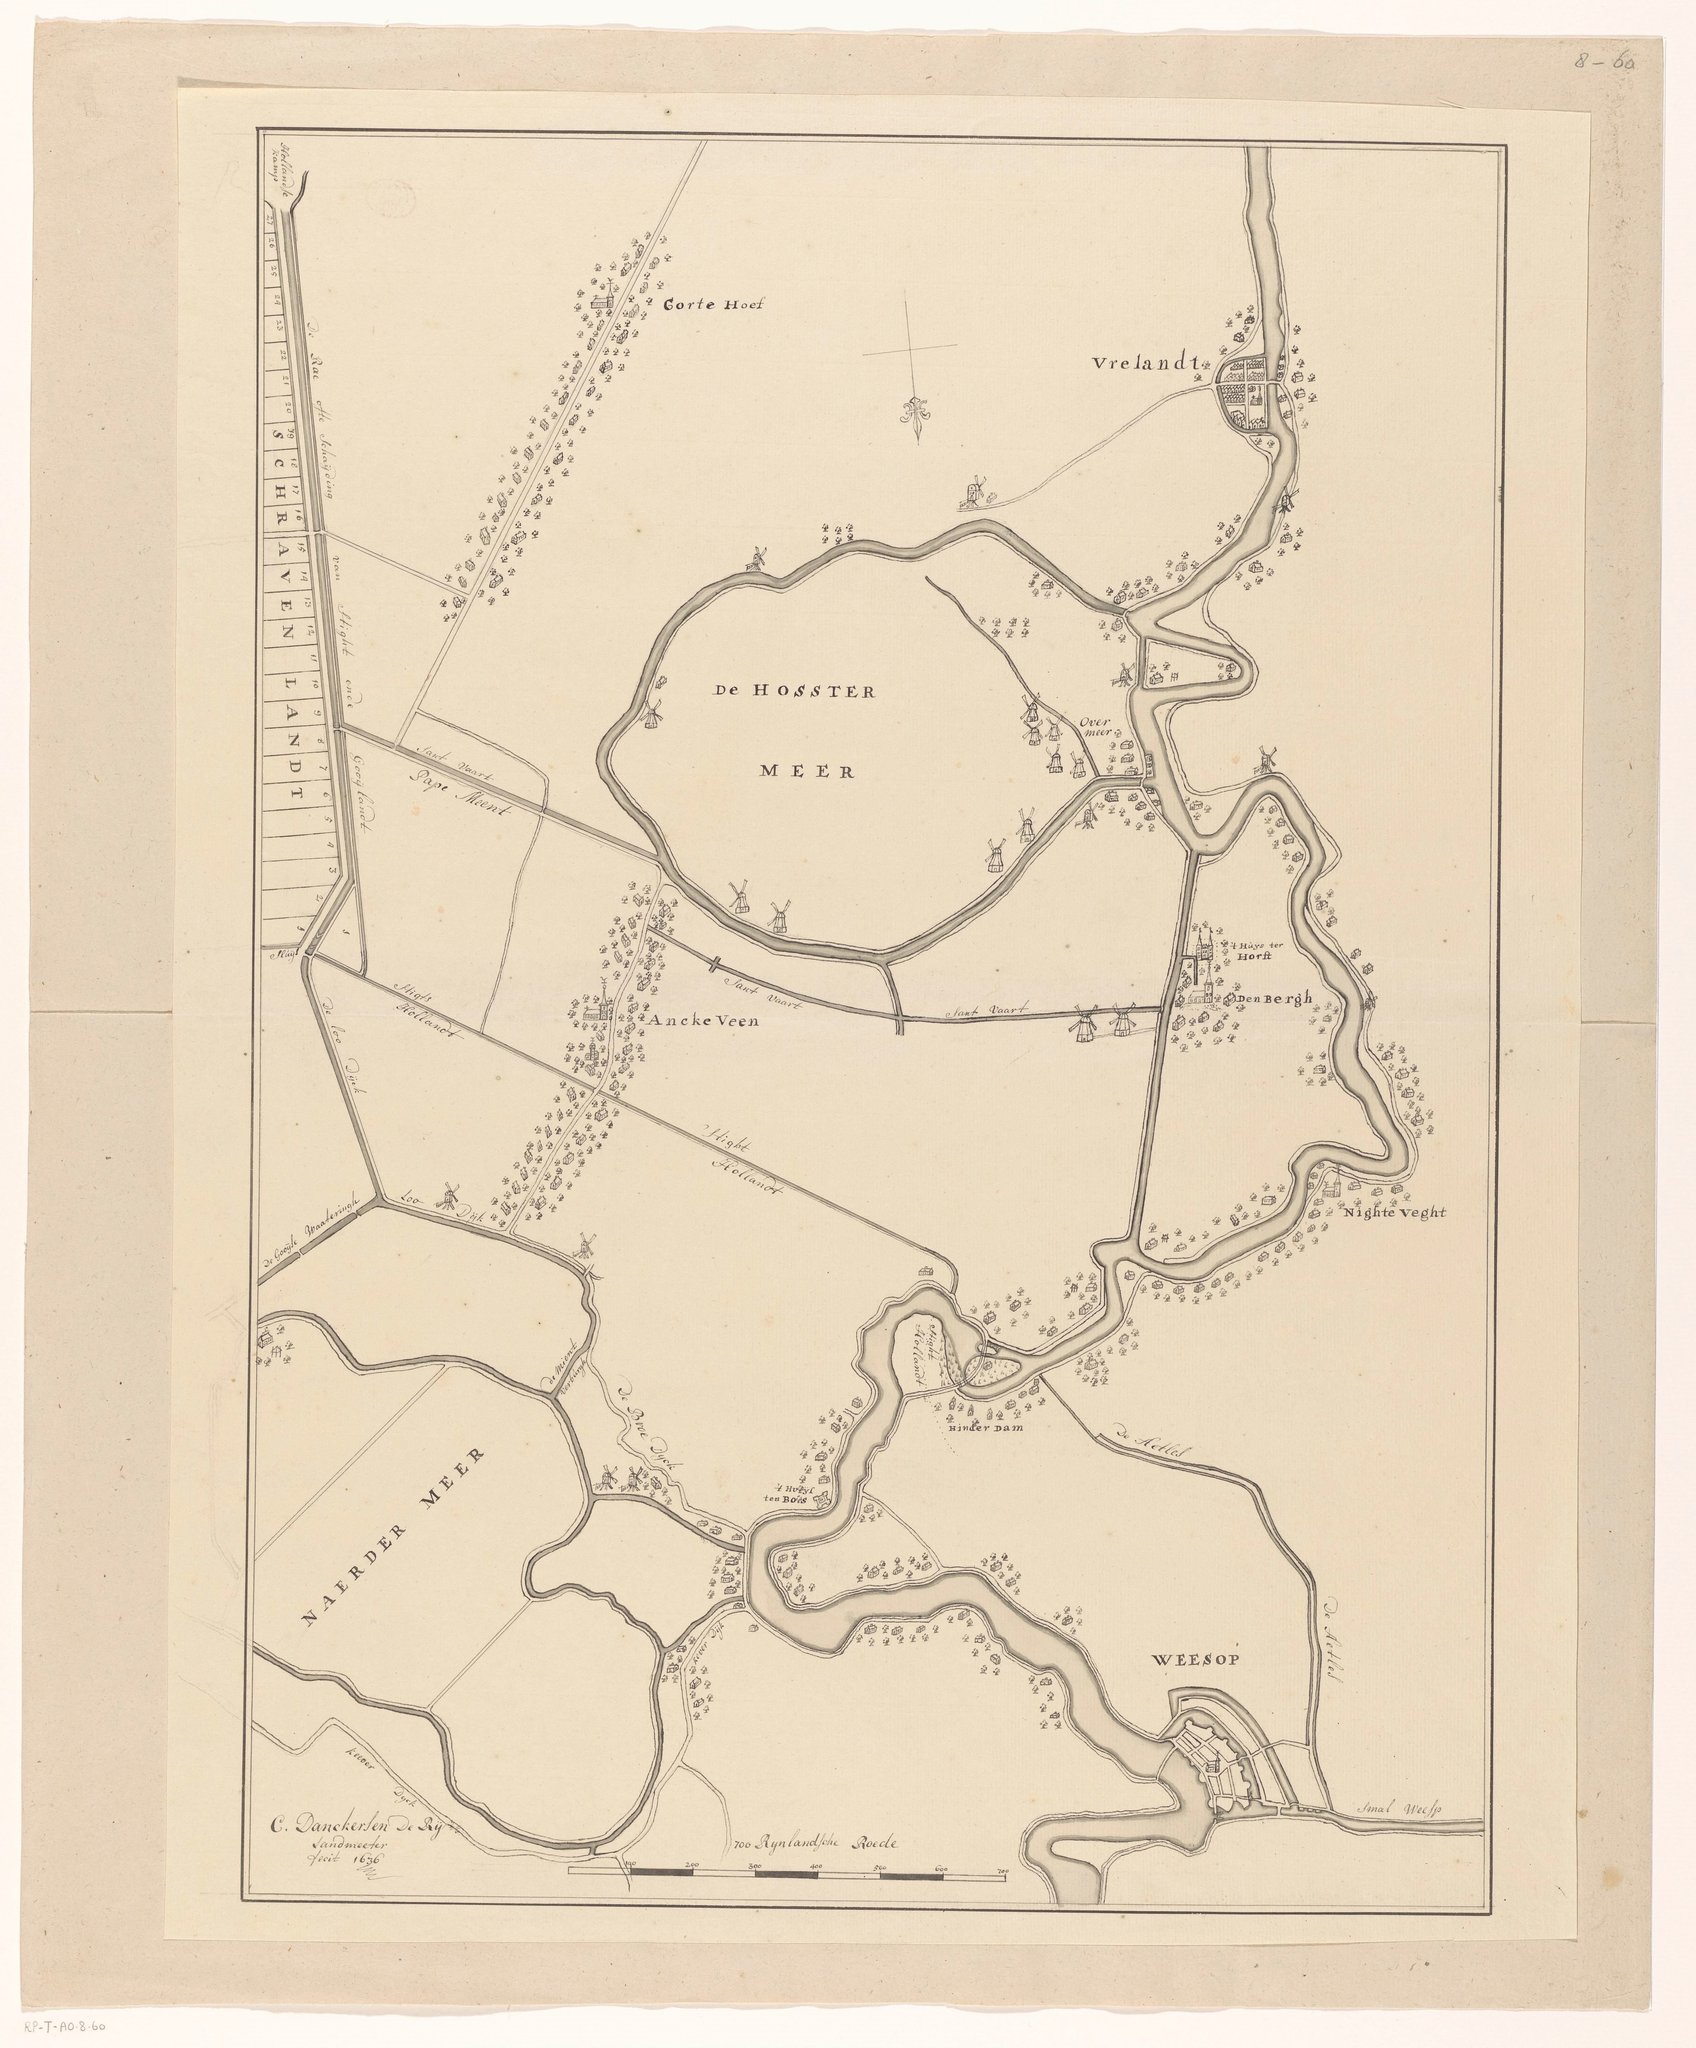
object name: map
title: Kaart van een deel van het Gooi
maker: cornelis danckerts de rij (ii)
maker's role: landmeter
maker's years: 1596-1662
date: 1636-1799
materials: ink, paper, pencil, watercolor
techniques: brush, pen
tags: maps of separate countries or regions, polder, reclaimed land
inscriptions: collector's mark: Lugt 195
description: Hoewel op deze kaart de naam van Cornelis Danckerts de Rij (II) en het jaartal 1636 staan, is er reden om te vermoeden dat dit niet klopt en dat de kaart later gedateerd dient te worden. Zowel het handschrift als het papier lijken eerder achttiende-eeuws dan uit 1636. Daarbij zijn er meerdere manuscriptkaarten van Danckerts de Rij te vinden in het Stadsarchief Amsterdam. De manier waarop hij deze kaarten heeft ondertekend is in geen geval gelijk of vergelijkbaar aan hoe de huidige kaart is ondertekend. Wel is er een andere manuscriptkaart van Danckerts de Rij uit 1636 bekend: een kaart van een deel van het Gooi met de nadruk op de zevenentwintig percelen van 'Nieuw Schravenland' (zie documentatie). Dit is het gebied waarvan op de huidige kaart linksboven een deel is afgebeeld ('Schraven Landt'). Het zou dus mogelijk kunnen zijn dat de huidige kaart door Danckerts de Rij is gemaakt als aanvulling op deze kaart. Gezien de hierboven genoemde bezwaren is het echter waarschijnlijker dat dit een latere kopie is van een (inmiddels verloren of onbekende) kaart van Danckerts de Rij uit 1636. Een andere mogelijkheid is dat dit een latere vervalsing is die voortborduurt op Danckerts de Rij’s kaart van 'Nieuw Schravenland'.